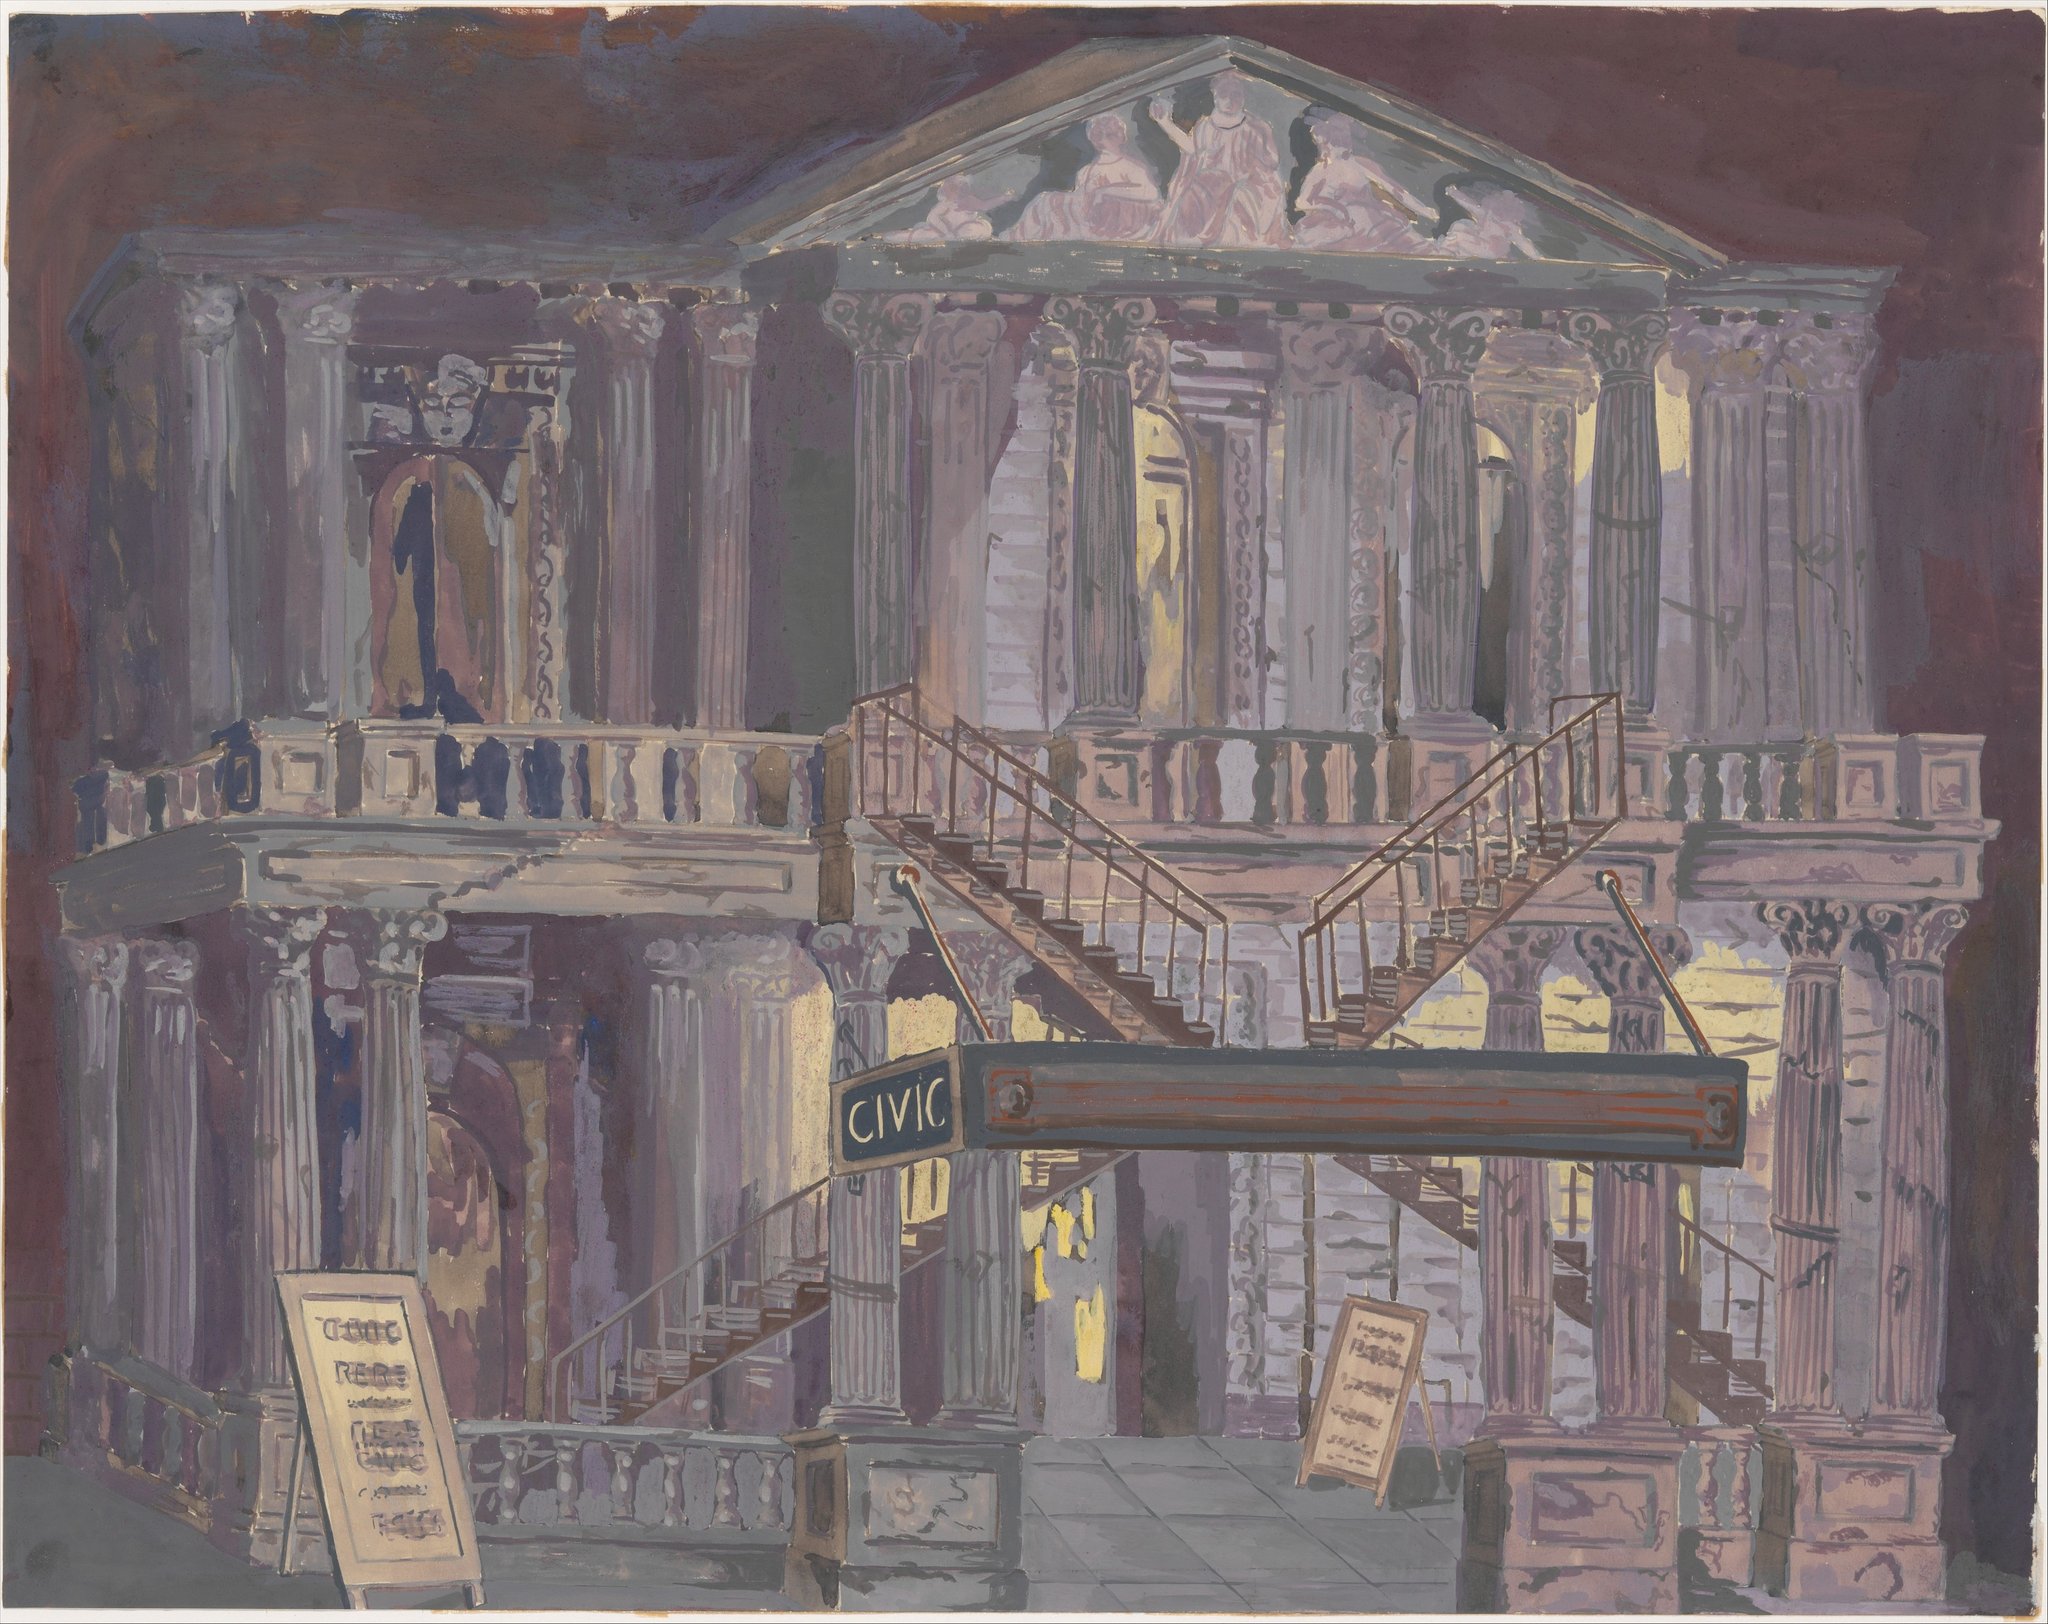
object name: drawing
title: 14th Street Theatre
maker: perkins harnly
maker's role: artist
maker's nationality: american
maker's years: 1901-1986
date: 1940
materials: paper, watercolor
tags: theatre